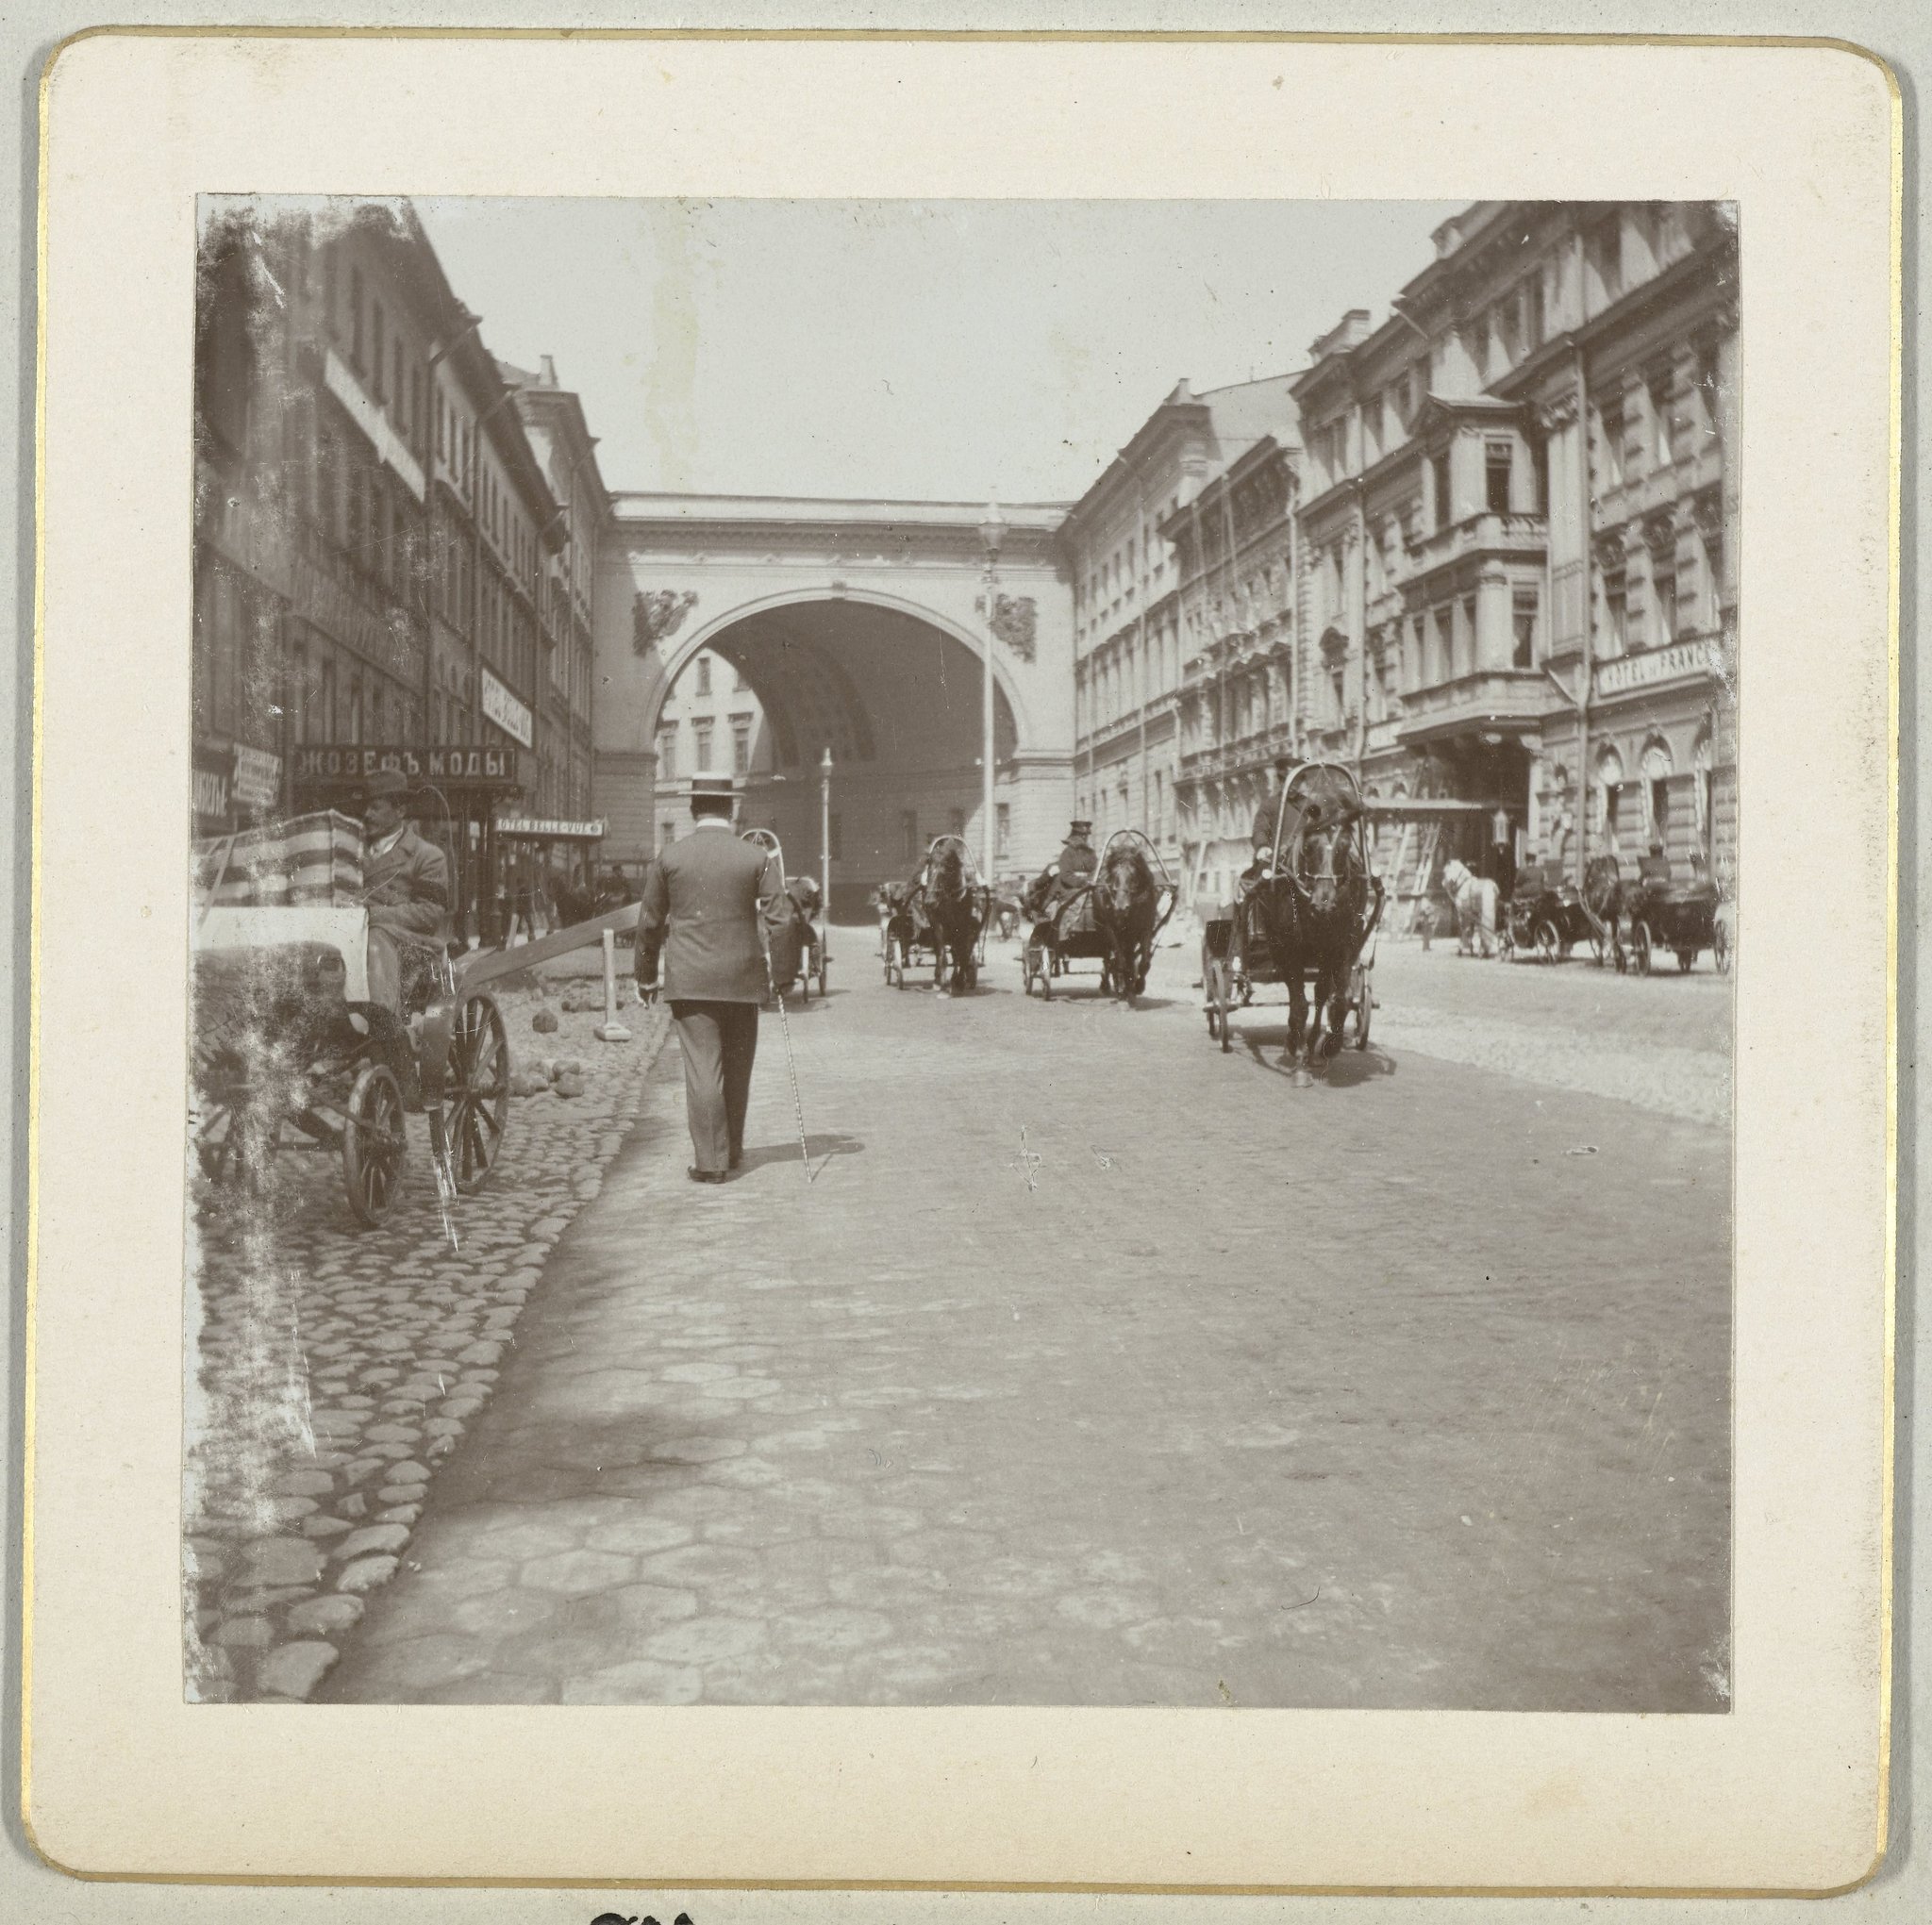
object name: photograph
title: St Petersburg, Morskaja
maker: henry pauw van wieldrecht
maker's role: fotograaf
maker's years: 1863-1912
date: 1898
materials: paper, photographic support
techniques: albumen print